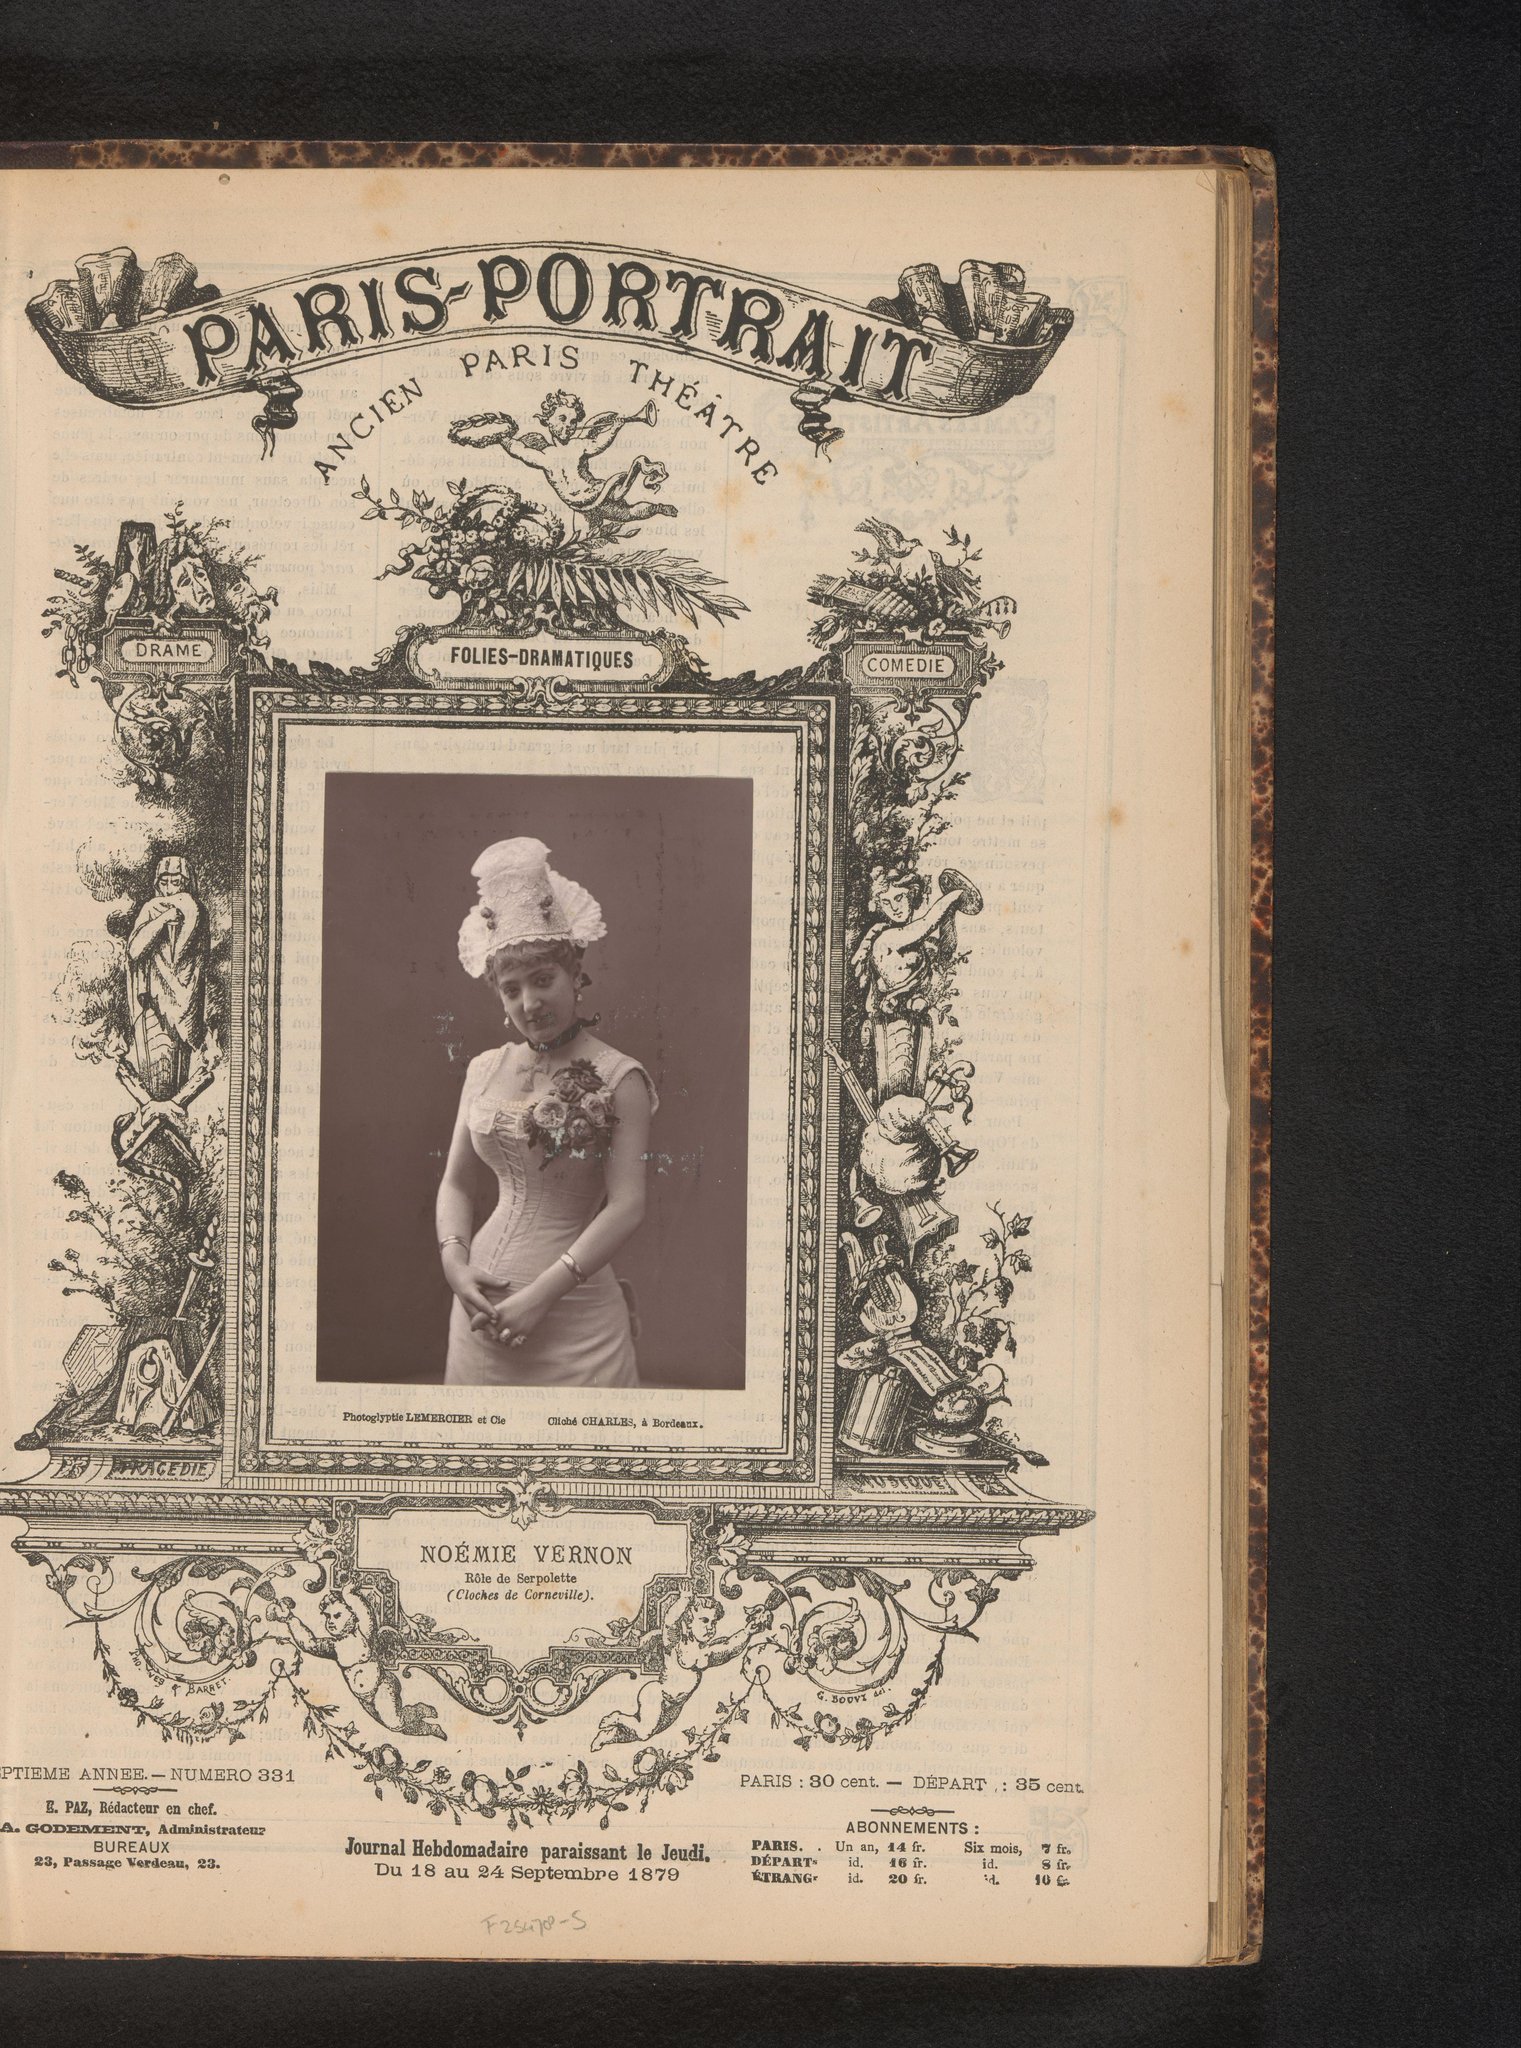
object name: photomechanical print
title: Portret van Noémie Vernon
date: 1873-1880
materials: paper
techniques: woodburytype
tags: historical persons - bb - woman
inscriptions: inscription: ‘Role de Serpolette (Cloches de Corneville)’